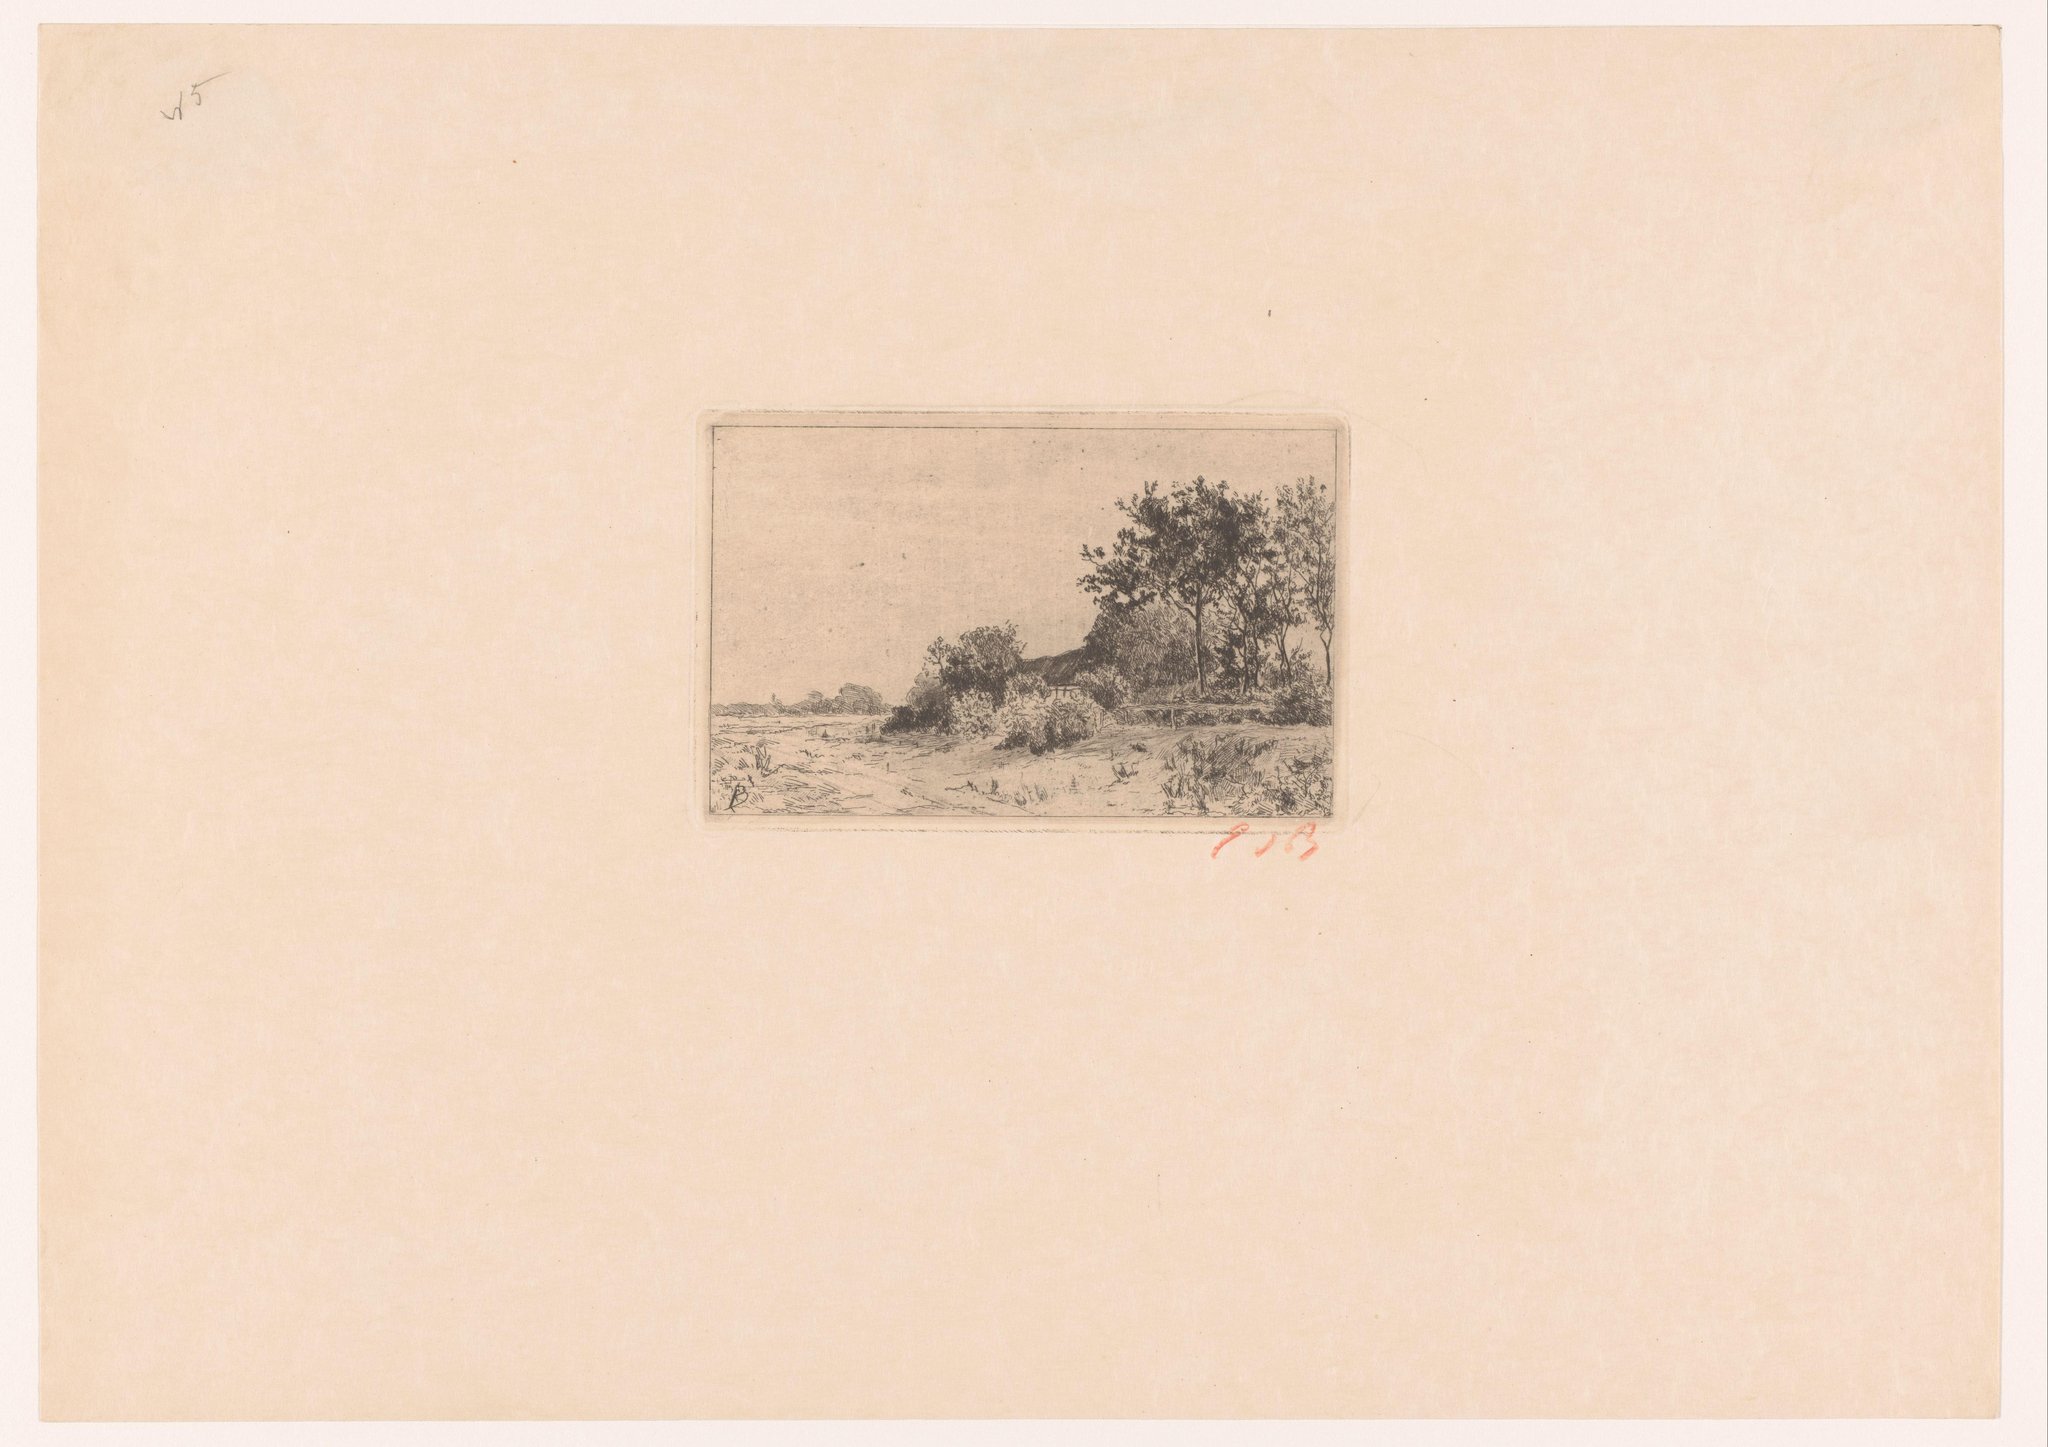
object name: print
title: Heidegezicht met een boerderij tussen bomen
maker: emile de baré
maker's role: painter, print maker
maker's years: 1855-1902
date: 1865-1902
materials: paper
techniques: etching, intaglio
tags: farm or solitary house in landscape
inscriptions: collector's mark: Lugt 2228